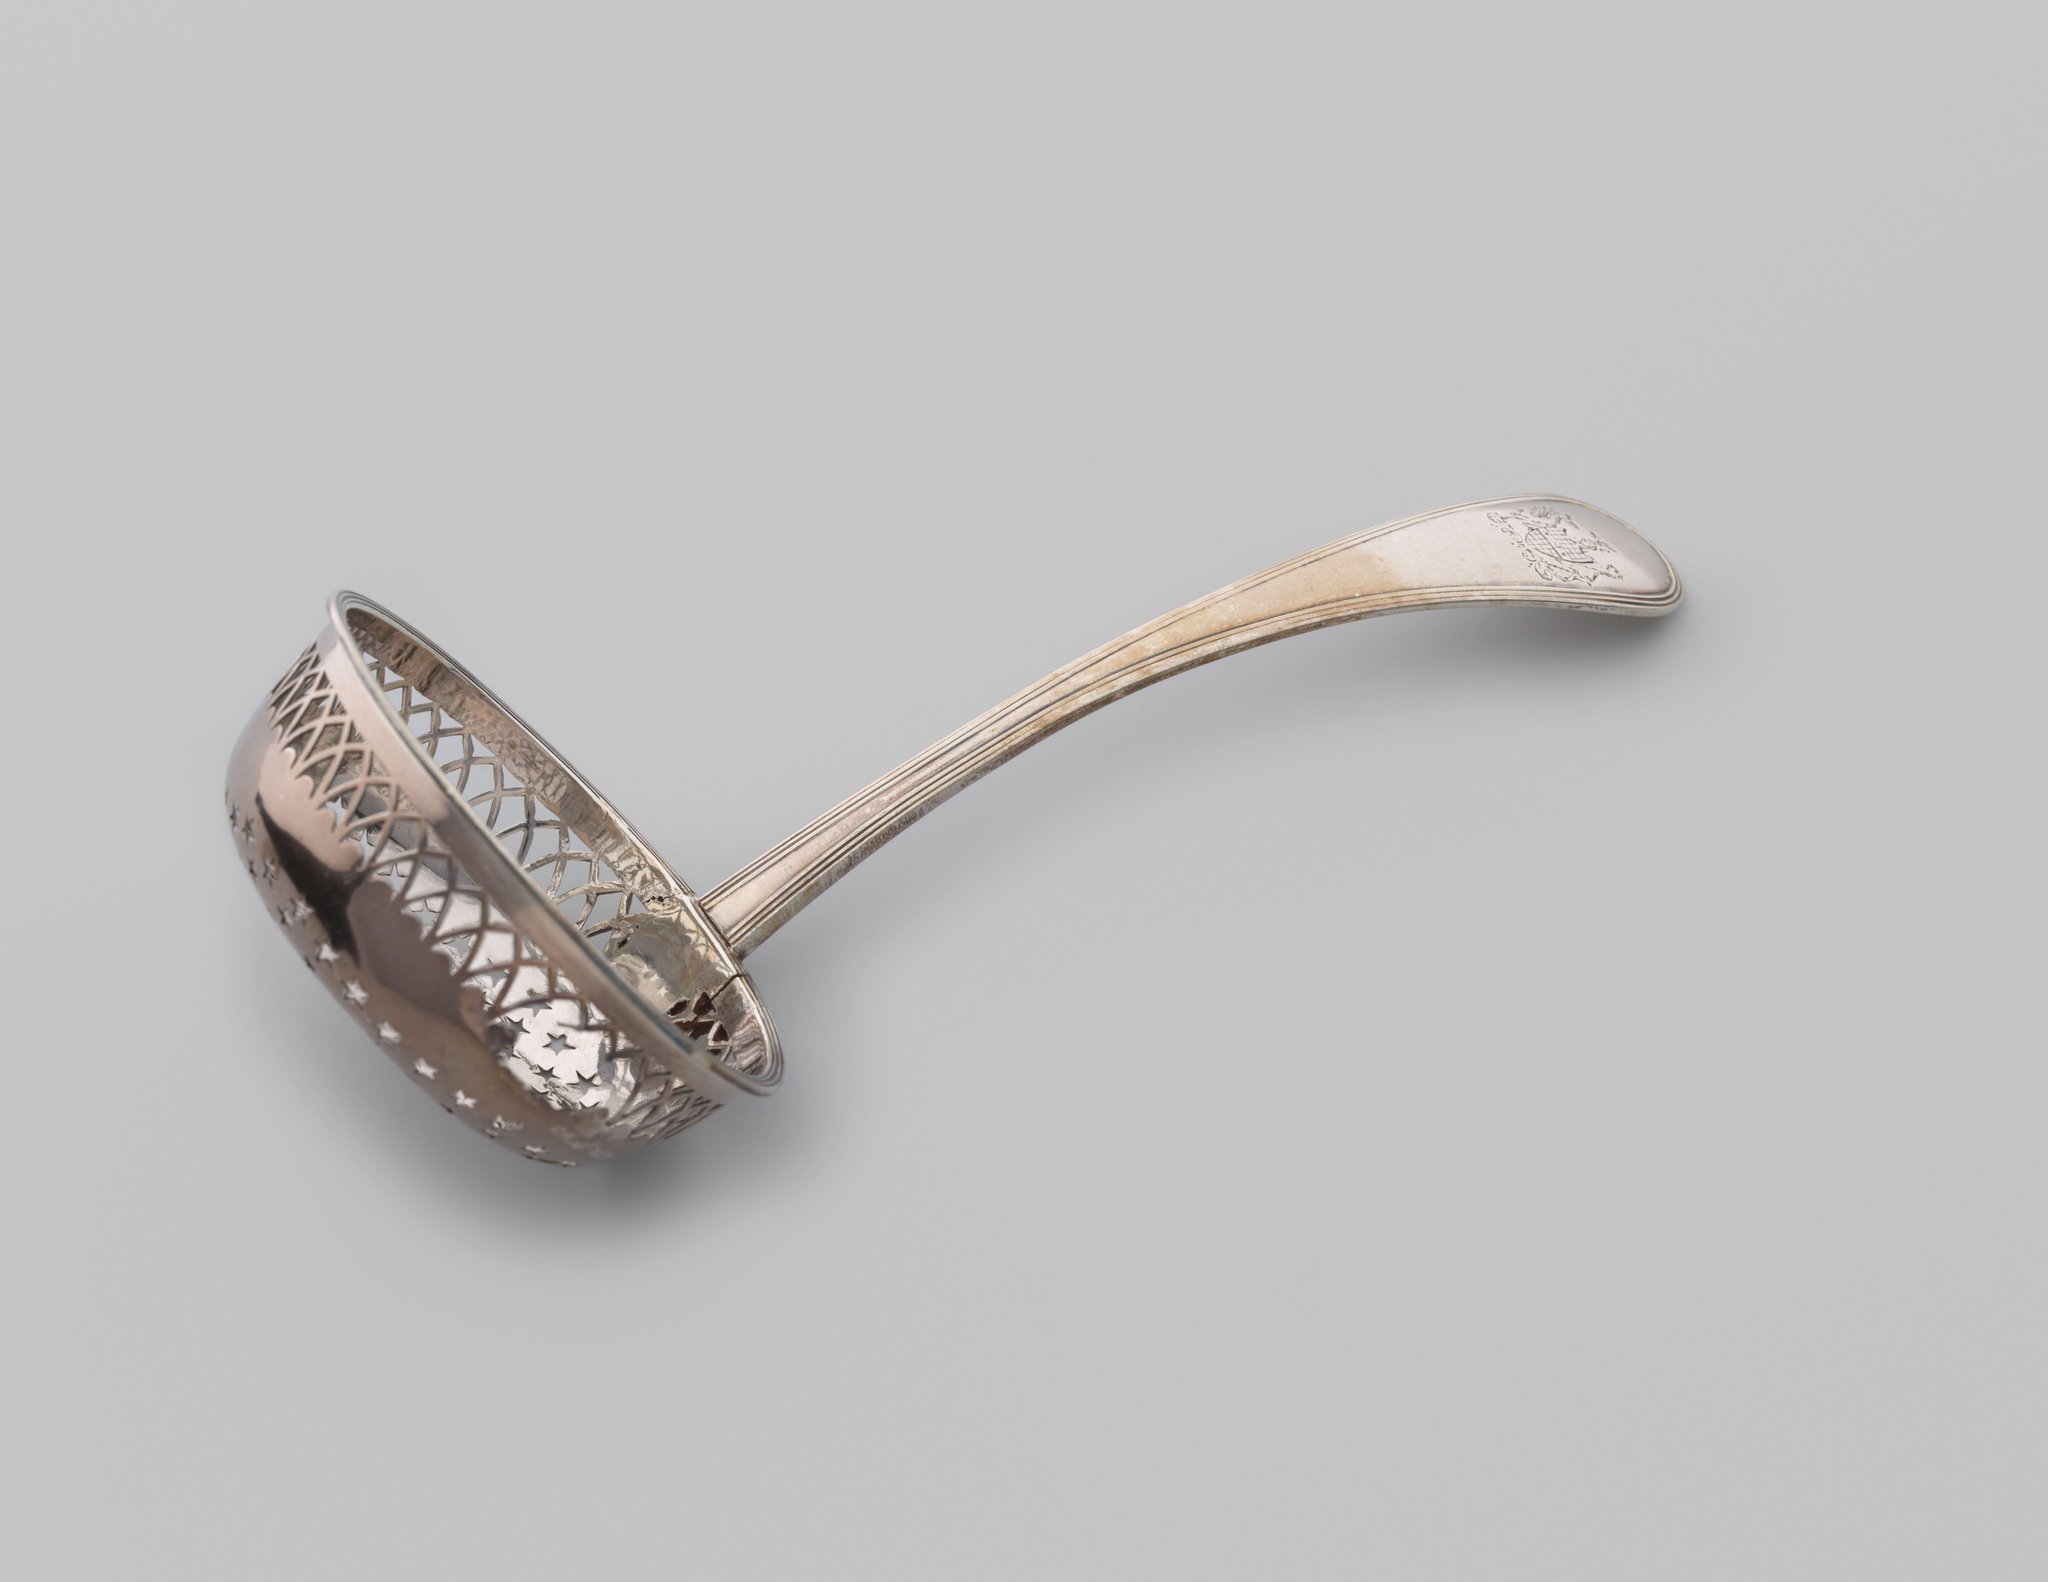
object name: spoon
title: Suikerstrooilepel met het familiewapen Clifford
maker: diederik lodewijk bennewitz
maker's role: silversmith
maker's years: 1763-1826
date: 1806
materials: silver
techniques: engraving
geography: amsterdam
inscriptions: maker's mark, date letter: ‘X’, town mark, alloy mark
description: De ronde, diepe bak heeft een platte bodem en wordt omgeven door een platte filetrand. De bak is opengewerkt met een patroon van sterren binnen een galerij van spitsbogen. De bak is door middel van enkel lof verbonden met de platte, gebogen steel, die zich verbreedt naar het afgeronde uiteinde en aan de bovenzijde omgeven wordt door een filetrand. Op de bovenzijde van de steel is het wapen Clifford met het helmteken en schildhouders gegraveerd.